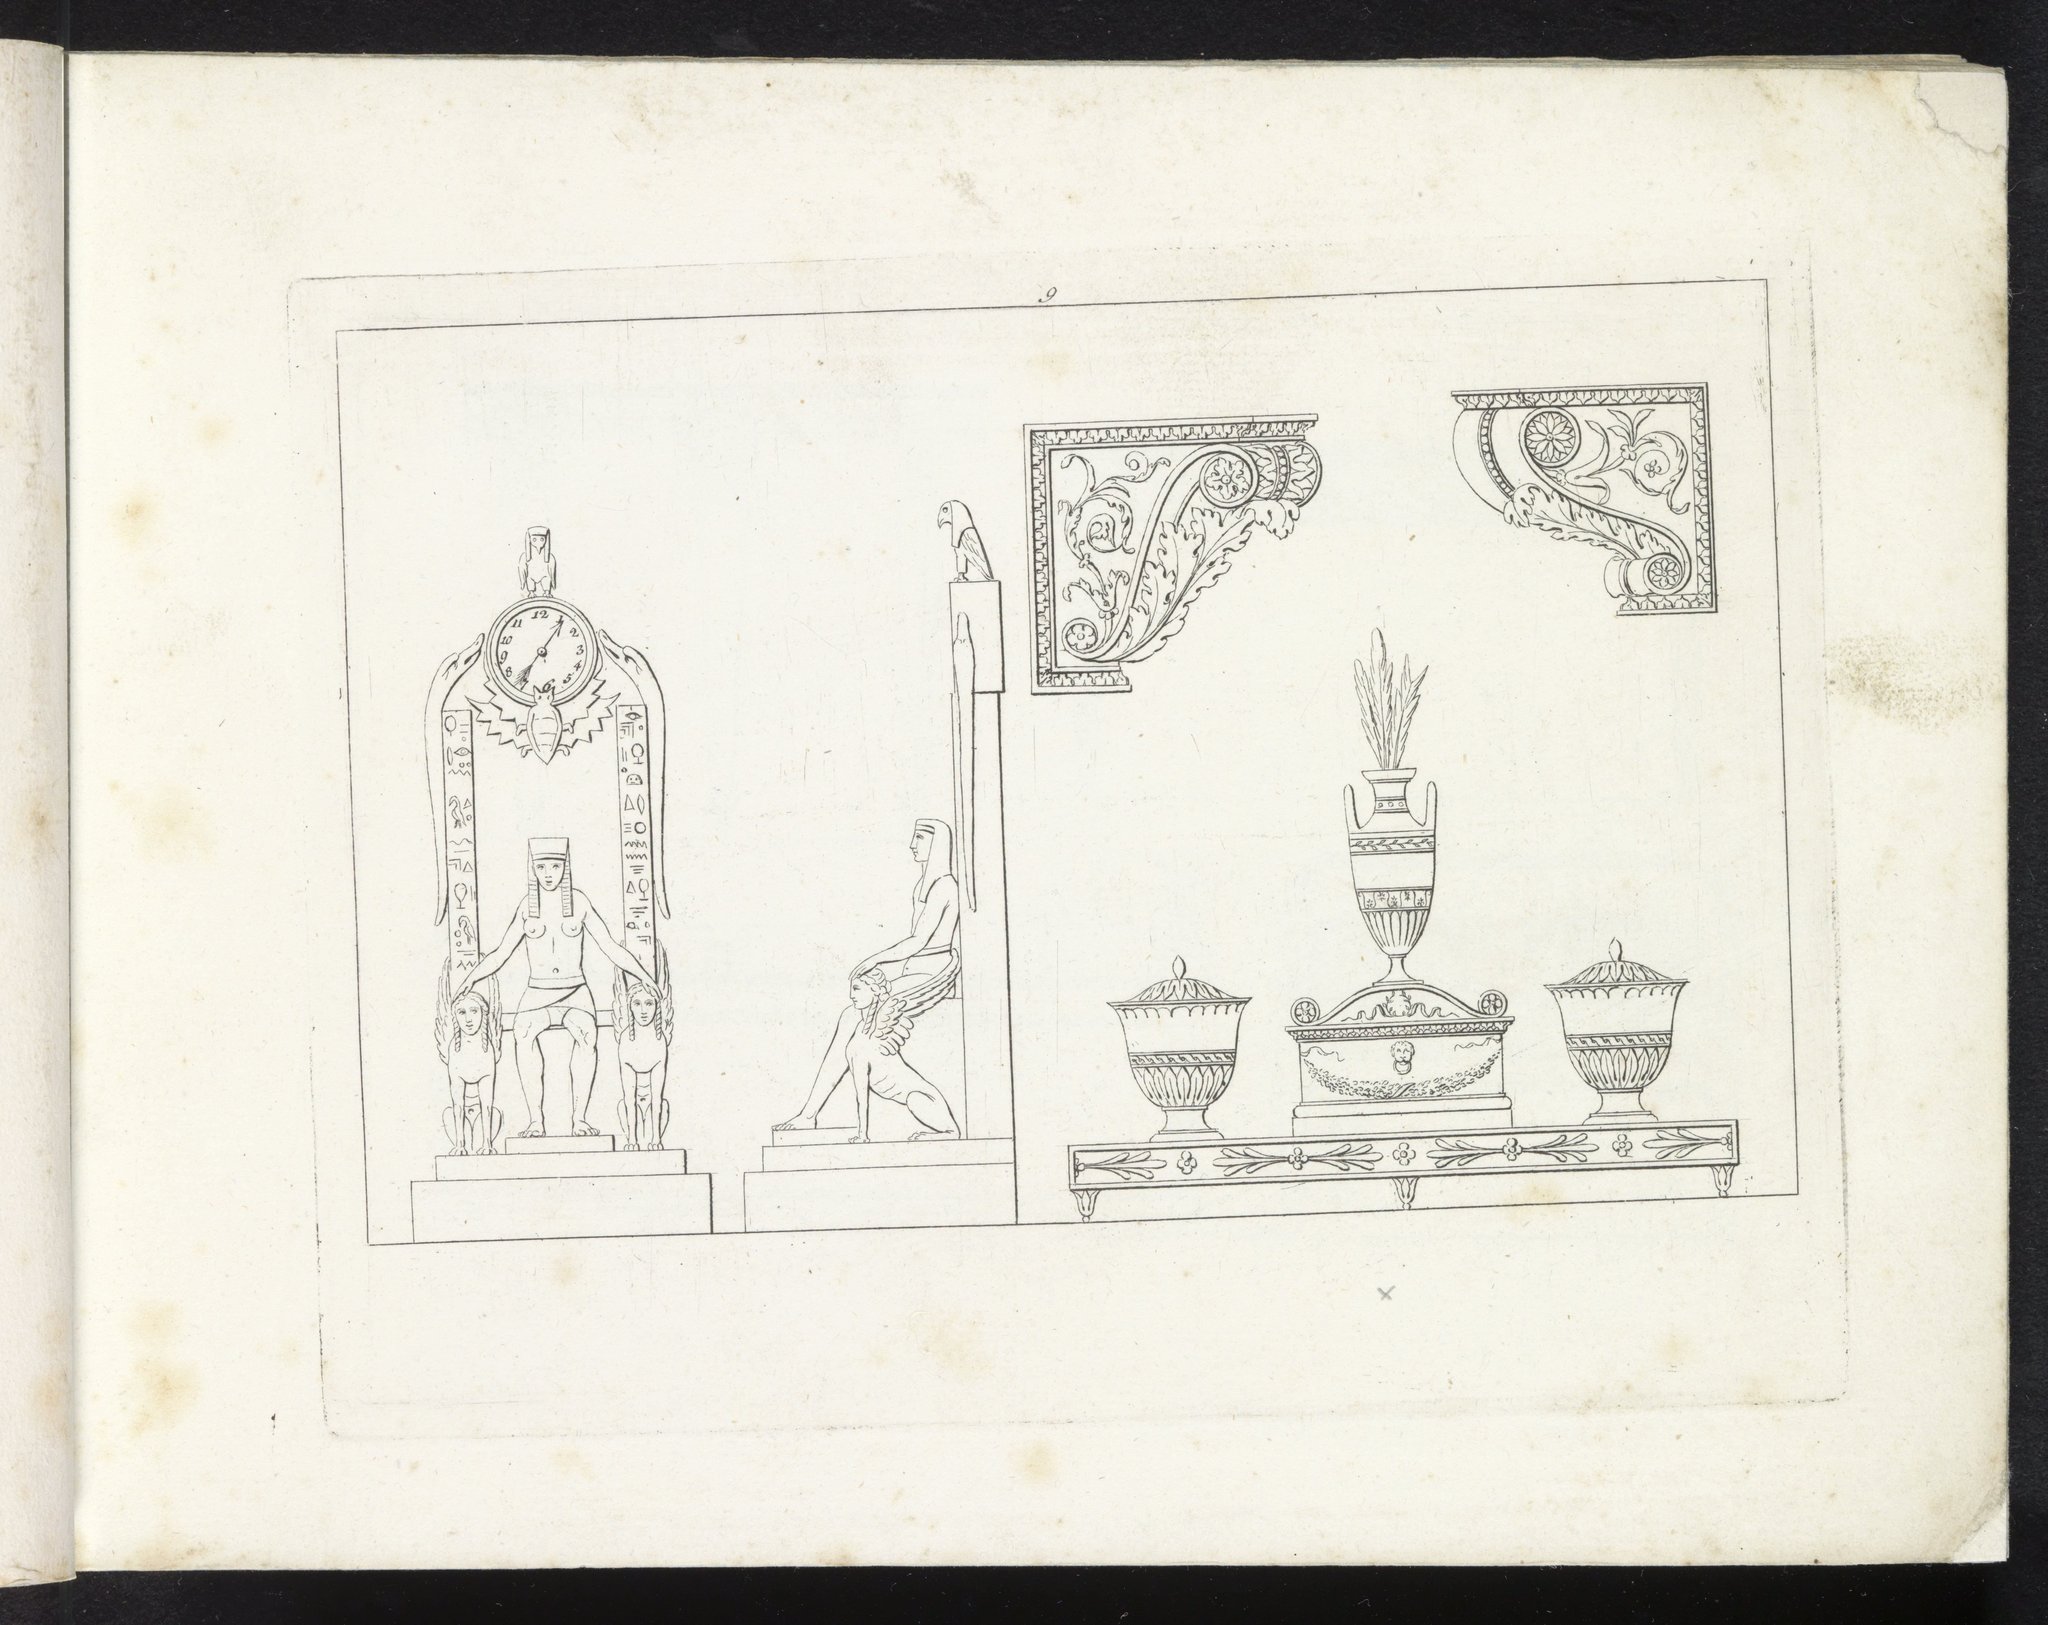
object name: print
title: Ontwerpen voor religieuze en profane voorwerpen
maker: pietro ruga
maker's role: print maker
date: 1817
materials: paper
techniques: etching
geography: milan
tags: ornamental cupboard, griffin (lion/eagle); 'griffo' (ripa), ornaments ~ art, bowl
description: Prent maakt deel uit van een reeks van 100 prenten (+ titelprent) met ontwerpen voor religieuze en profane voorwerpen.